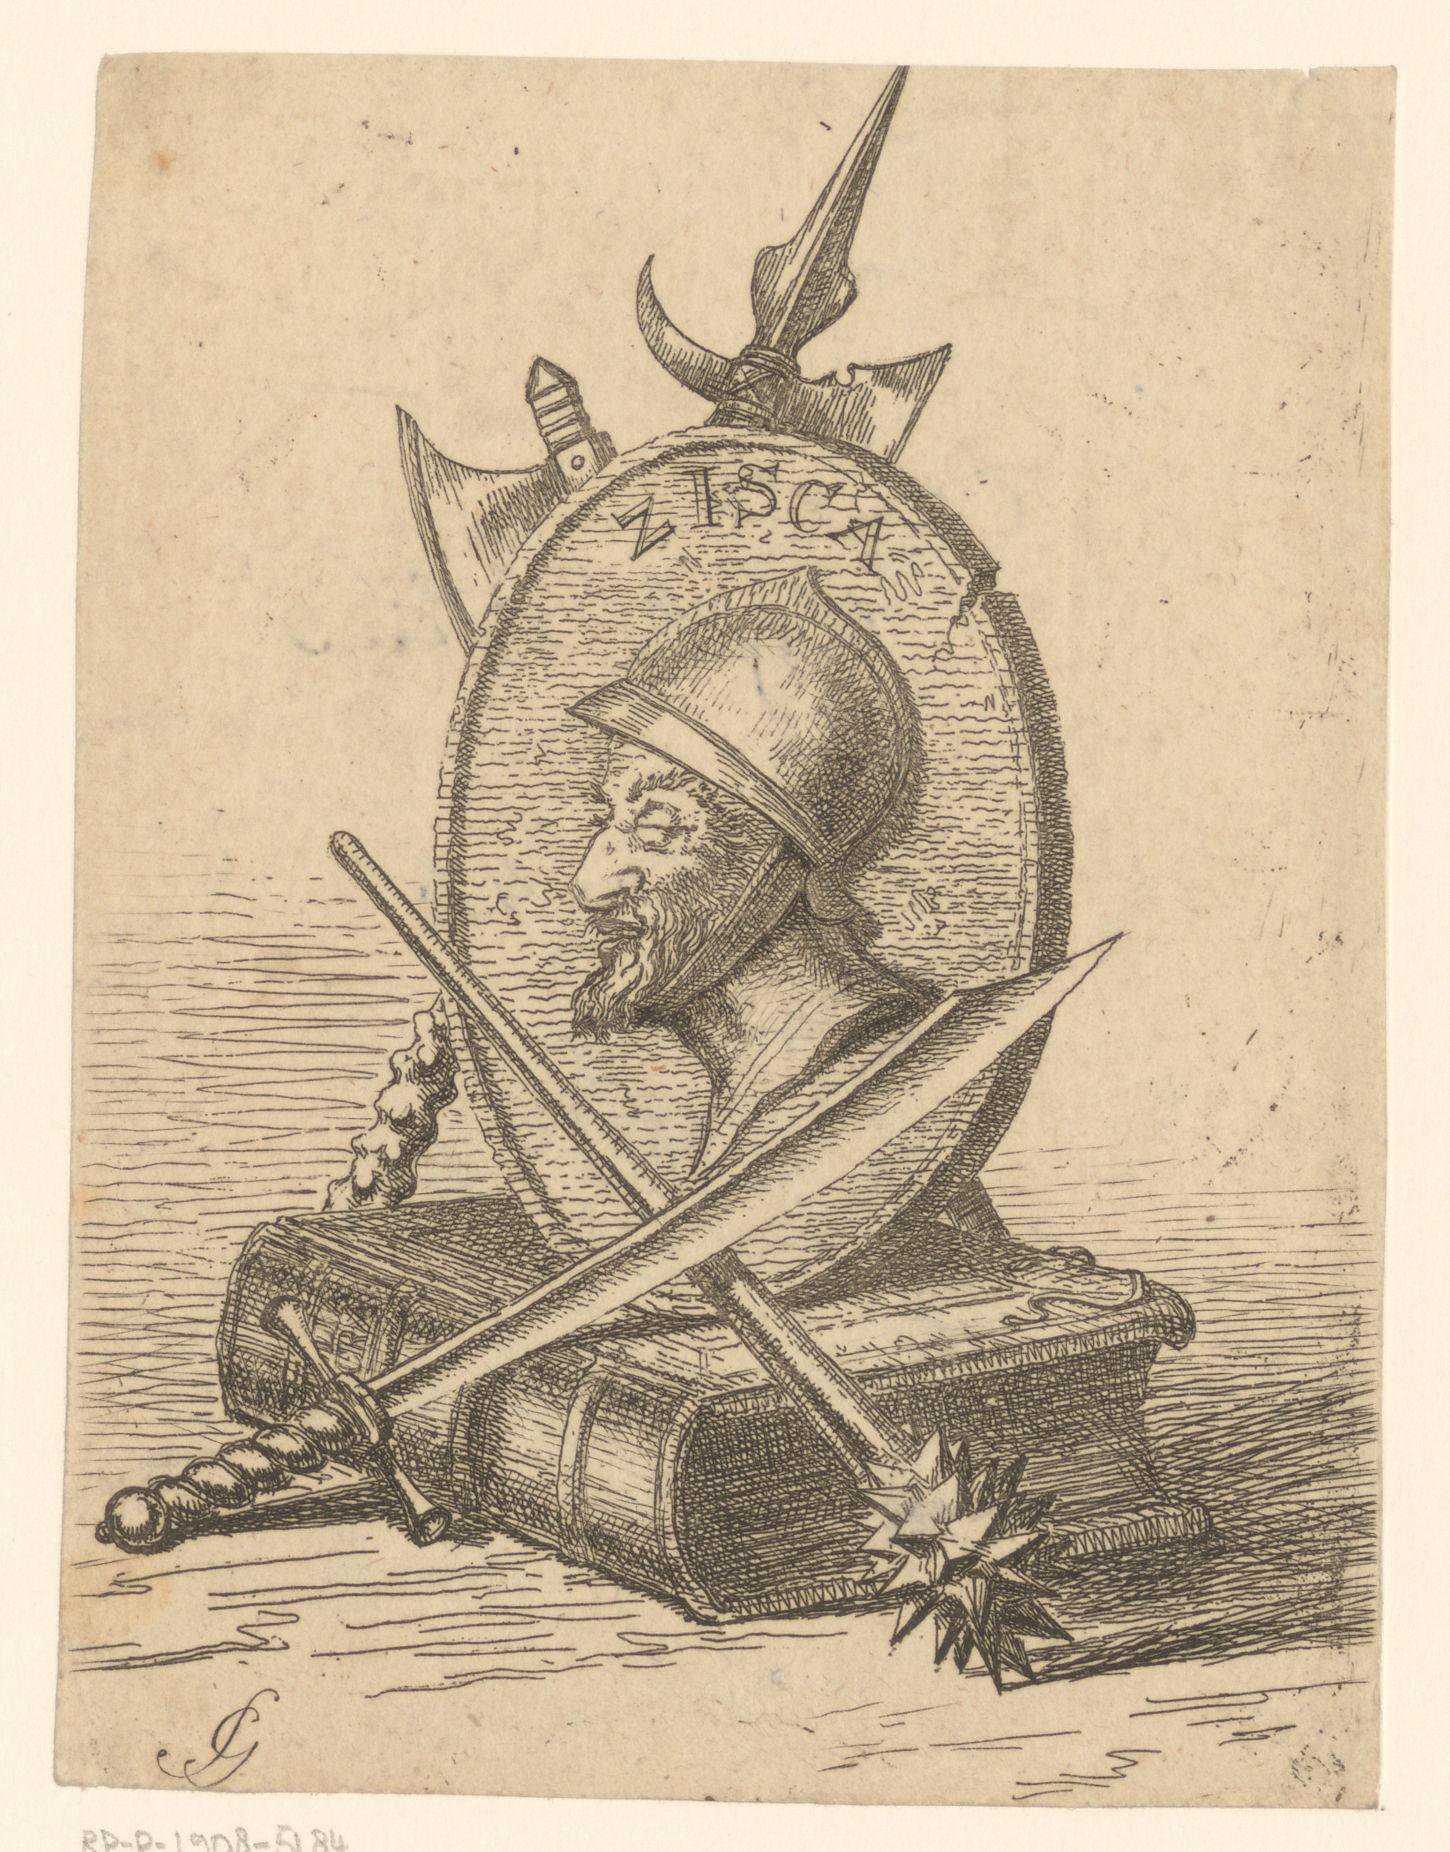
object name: print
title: Portret van onbekende man, mogelijk genaamd 'Zisca’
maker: sawrey gilpin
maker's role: print maker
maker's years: 1733-1807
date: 1743-1807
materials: paper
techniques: etching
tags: historical persons, weapons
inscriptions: collector's mark: Lugt 2228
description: Het portretmedaillon wordt ondersteund door wapens en een boek.